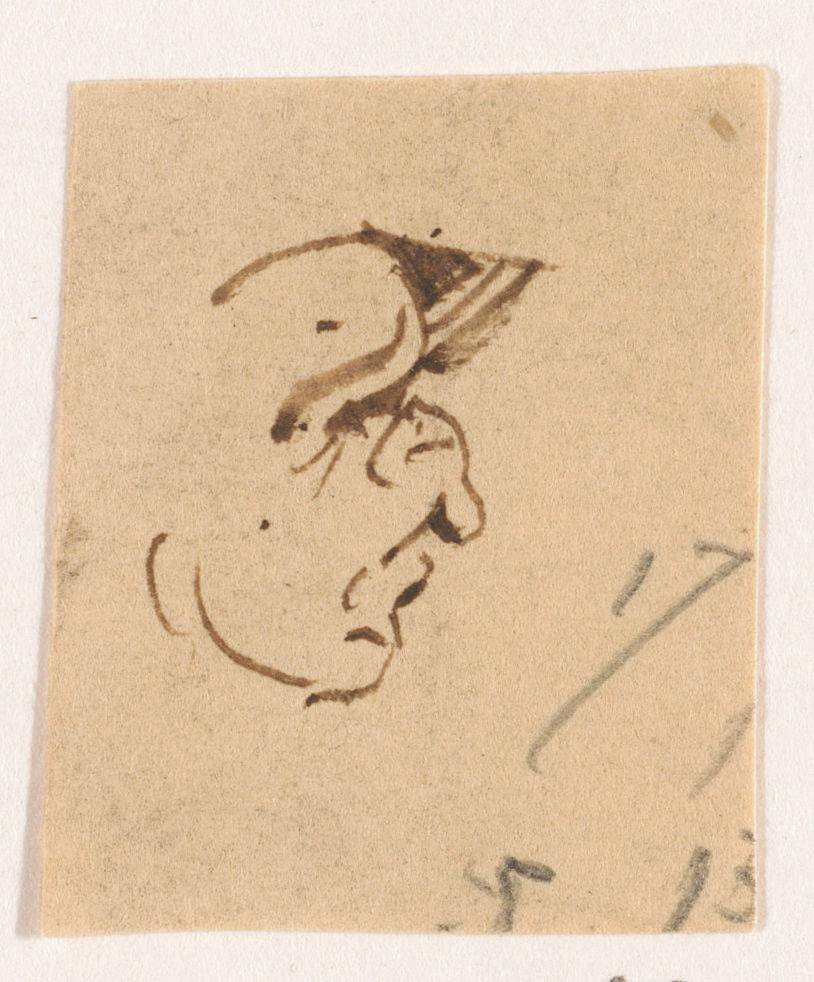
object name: drawing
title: Kop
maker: johannes tavenraat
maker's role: draughtsman, painter, print maker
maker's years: 1809-1881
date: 1840-1880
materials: ink, paper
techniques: pen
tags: caricatures (human types)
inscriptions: collector's mark: Lugt 2228